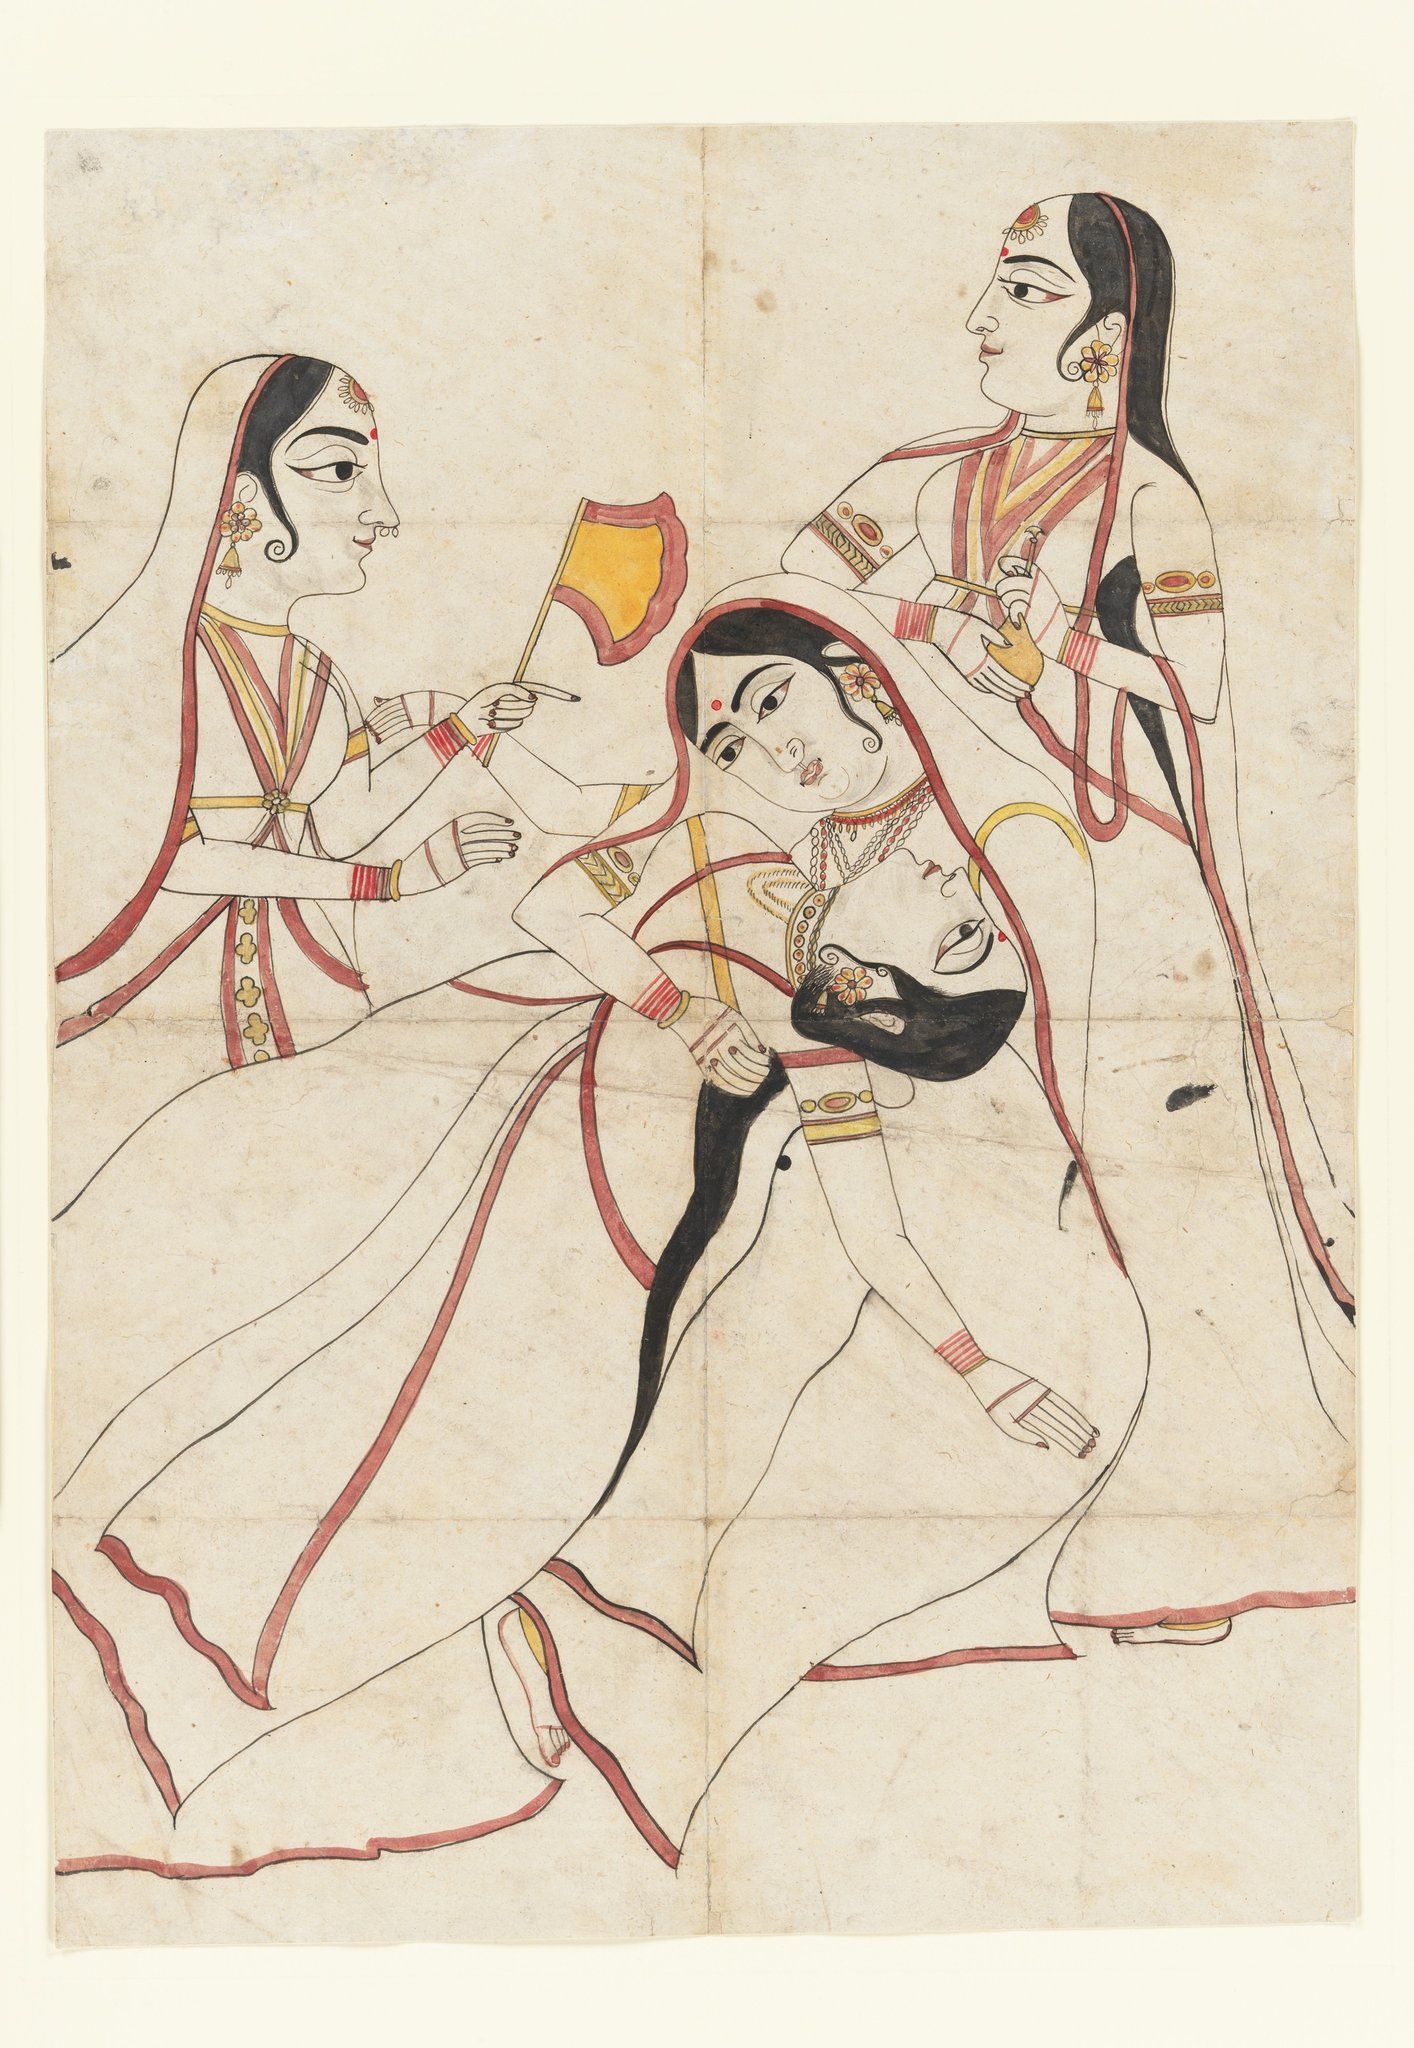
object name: painting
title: A Swooning Lady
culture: indian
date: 1867-1900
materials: ink, paper, watercolor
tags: fans,illness,women